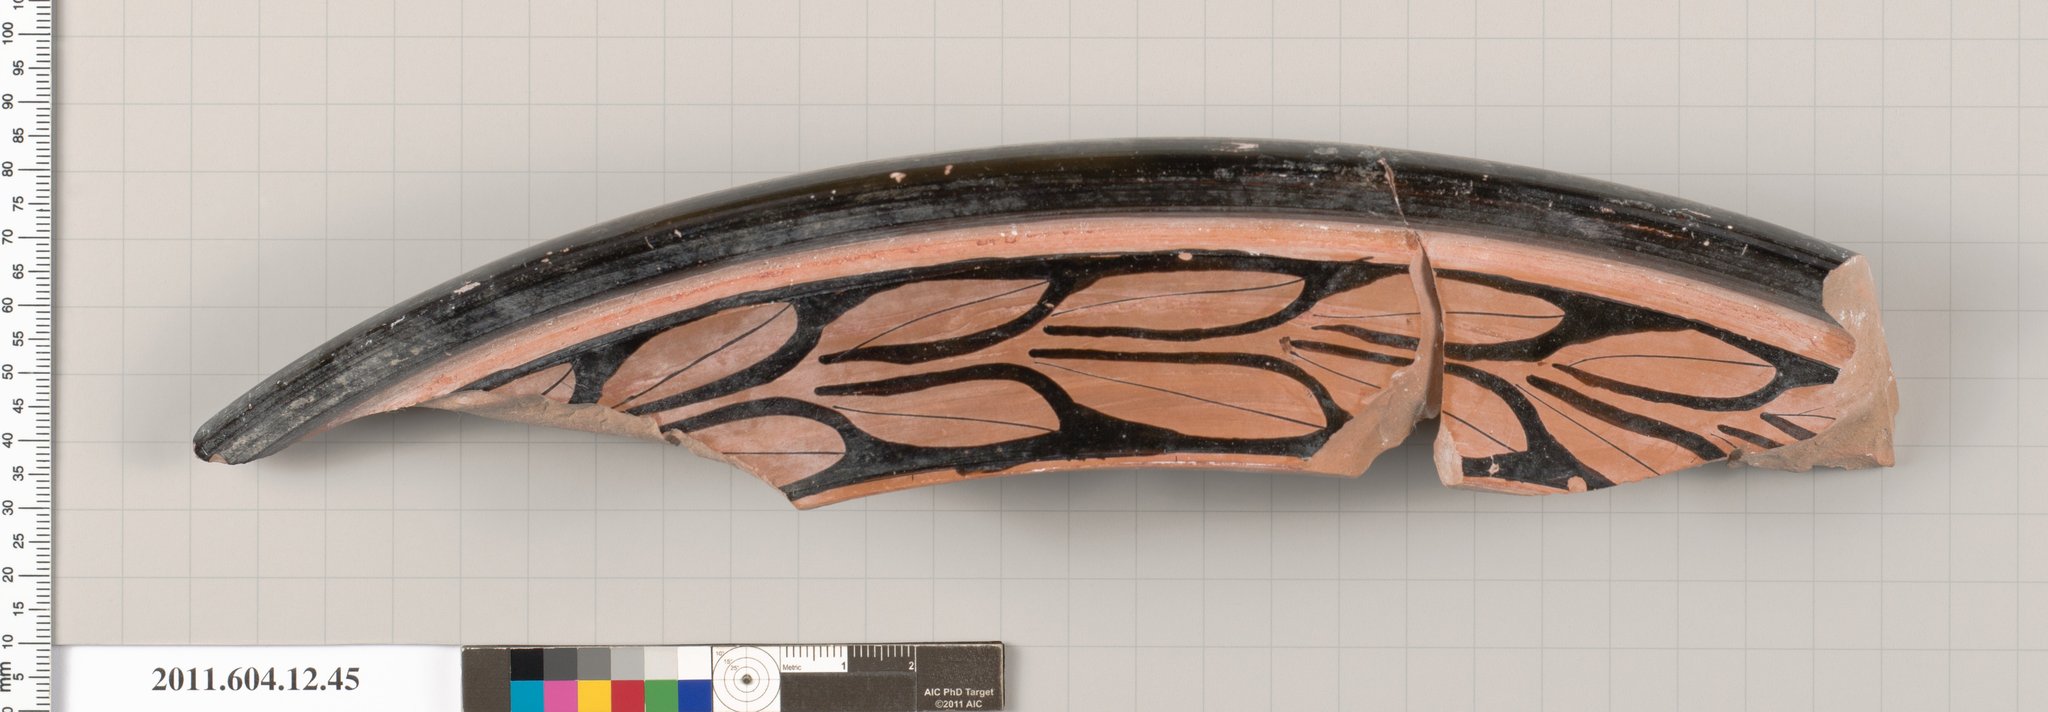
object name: bell krater fragment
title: Terracotta fragment of a bell-krater (deep bowl)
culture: greek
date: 434-401 BCE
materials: terracotta